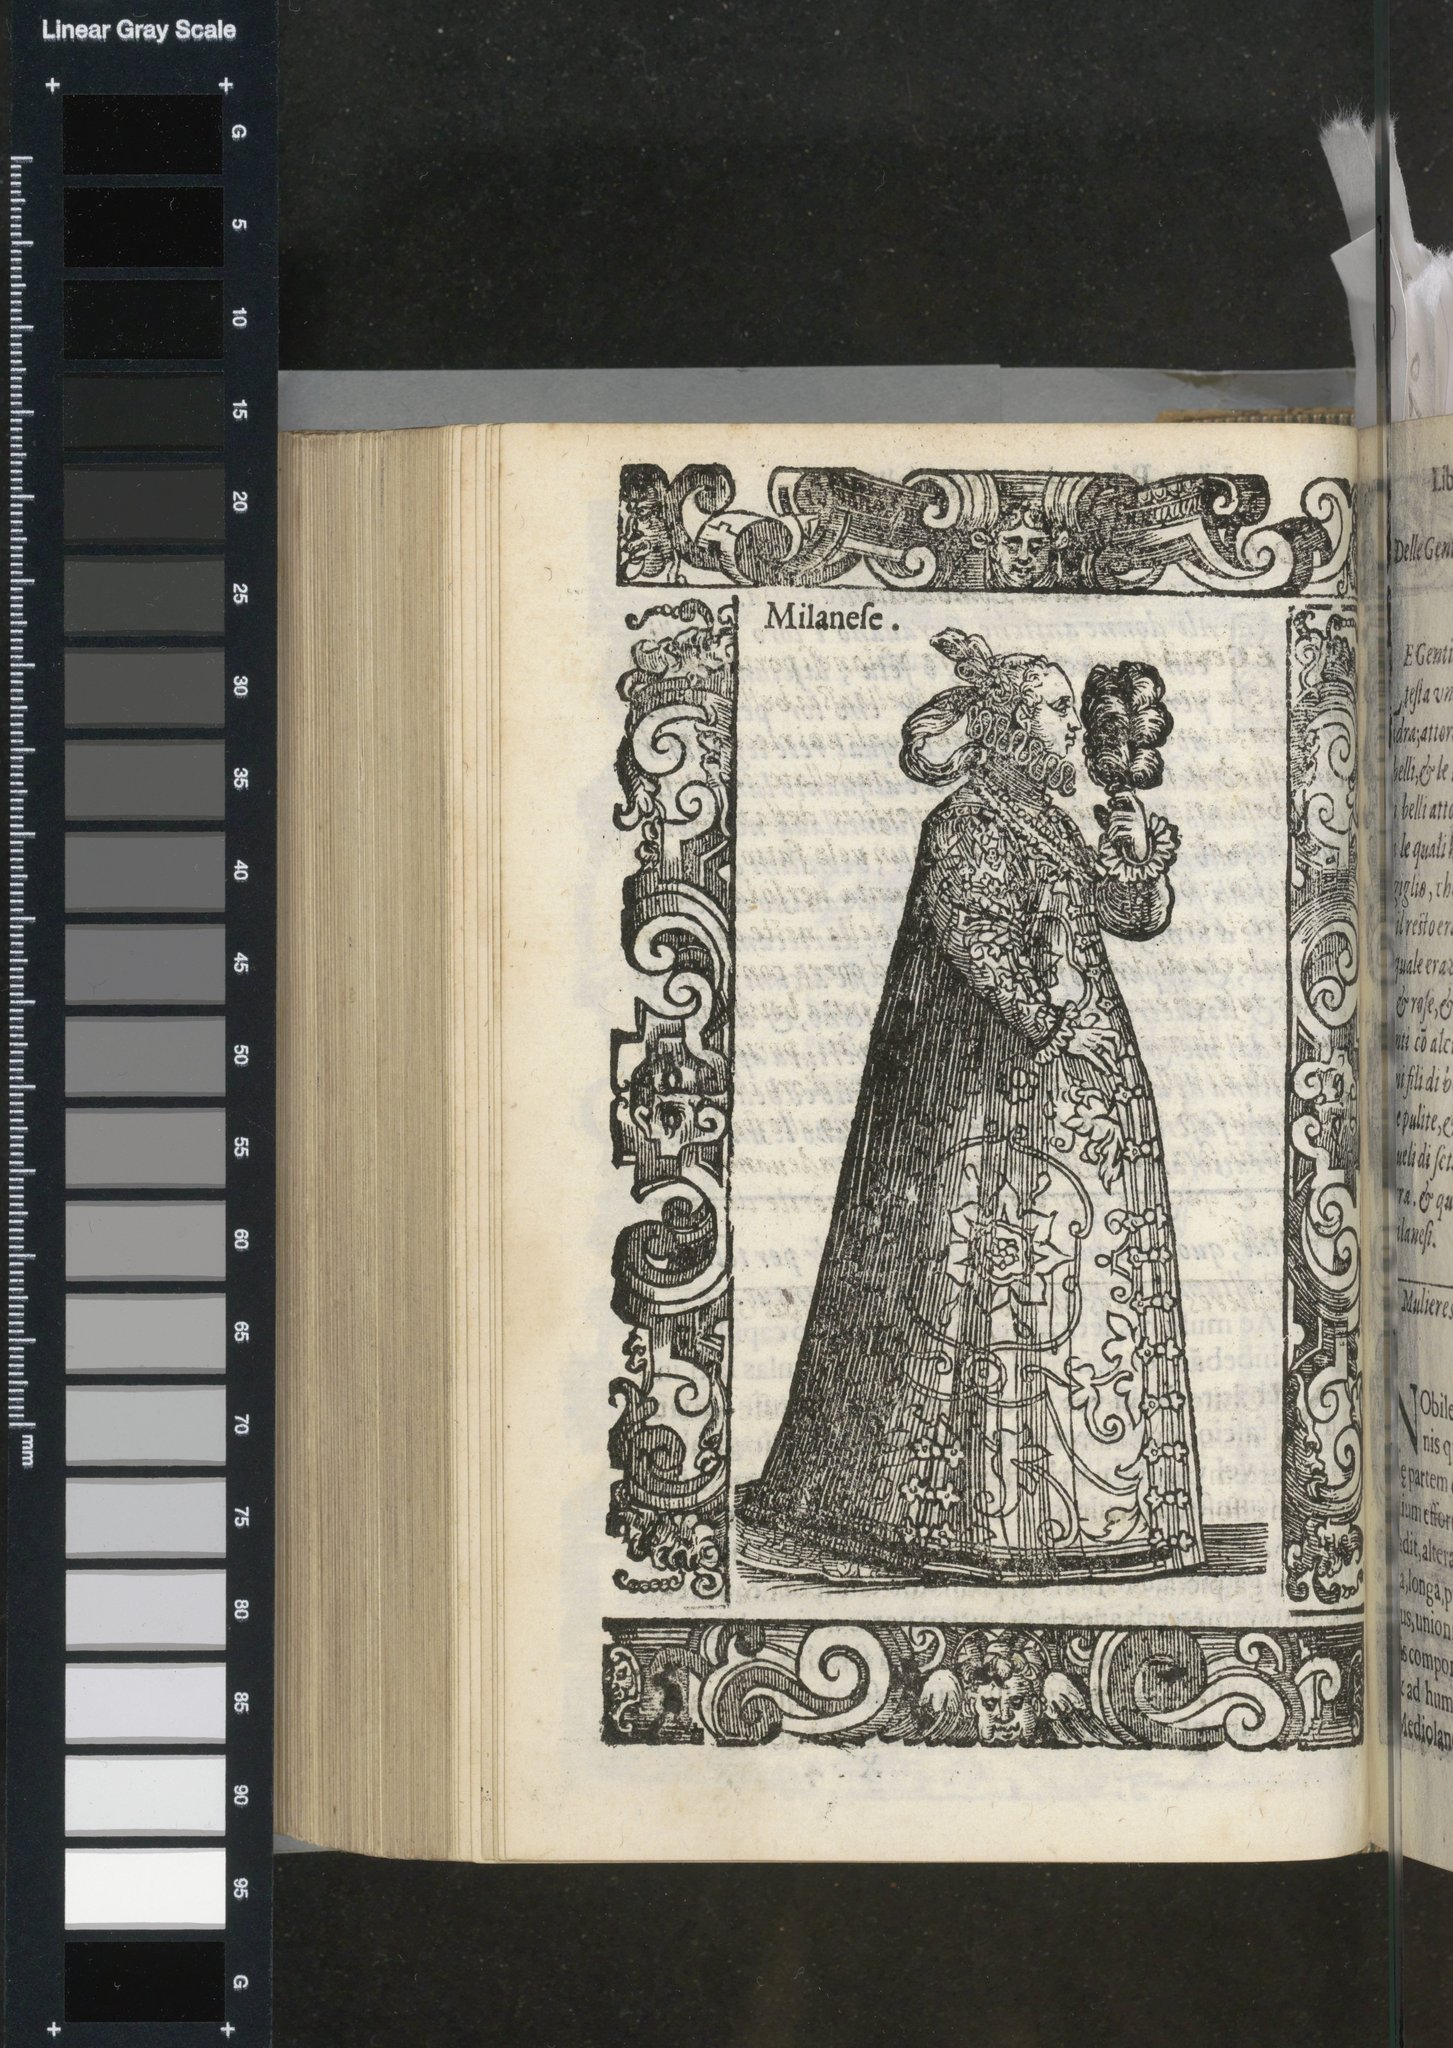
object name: costume print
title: Milanese (met waaier)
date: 1598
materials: paper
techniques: woodcut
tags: fashion plates